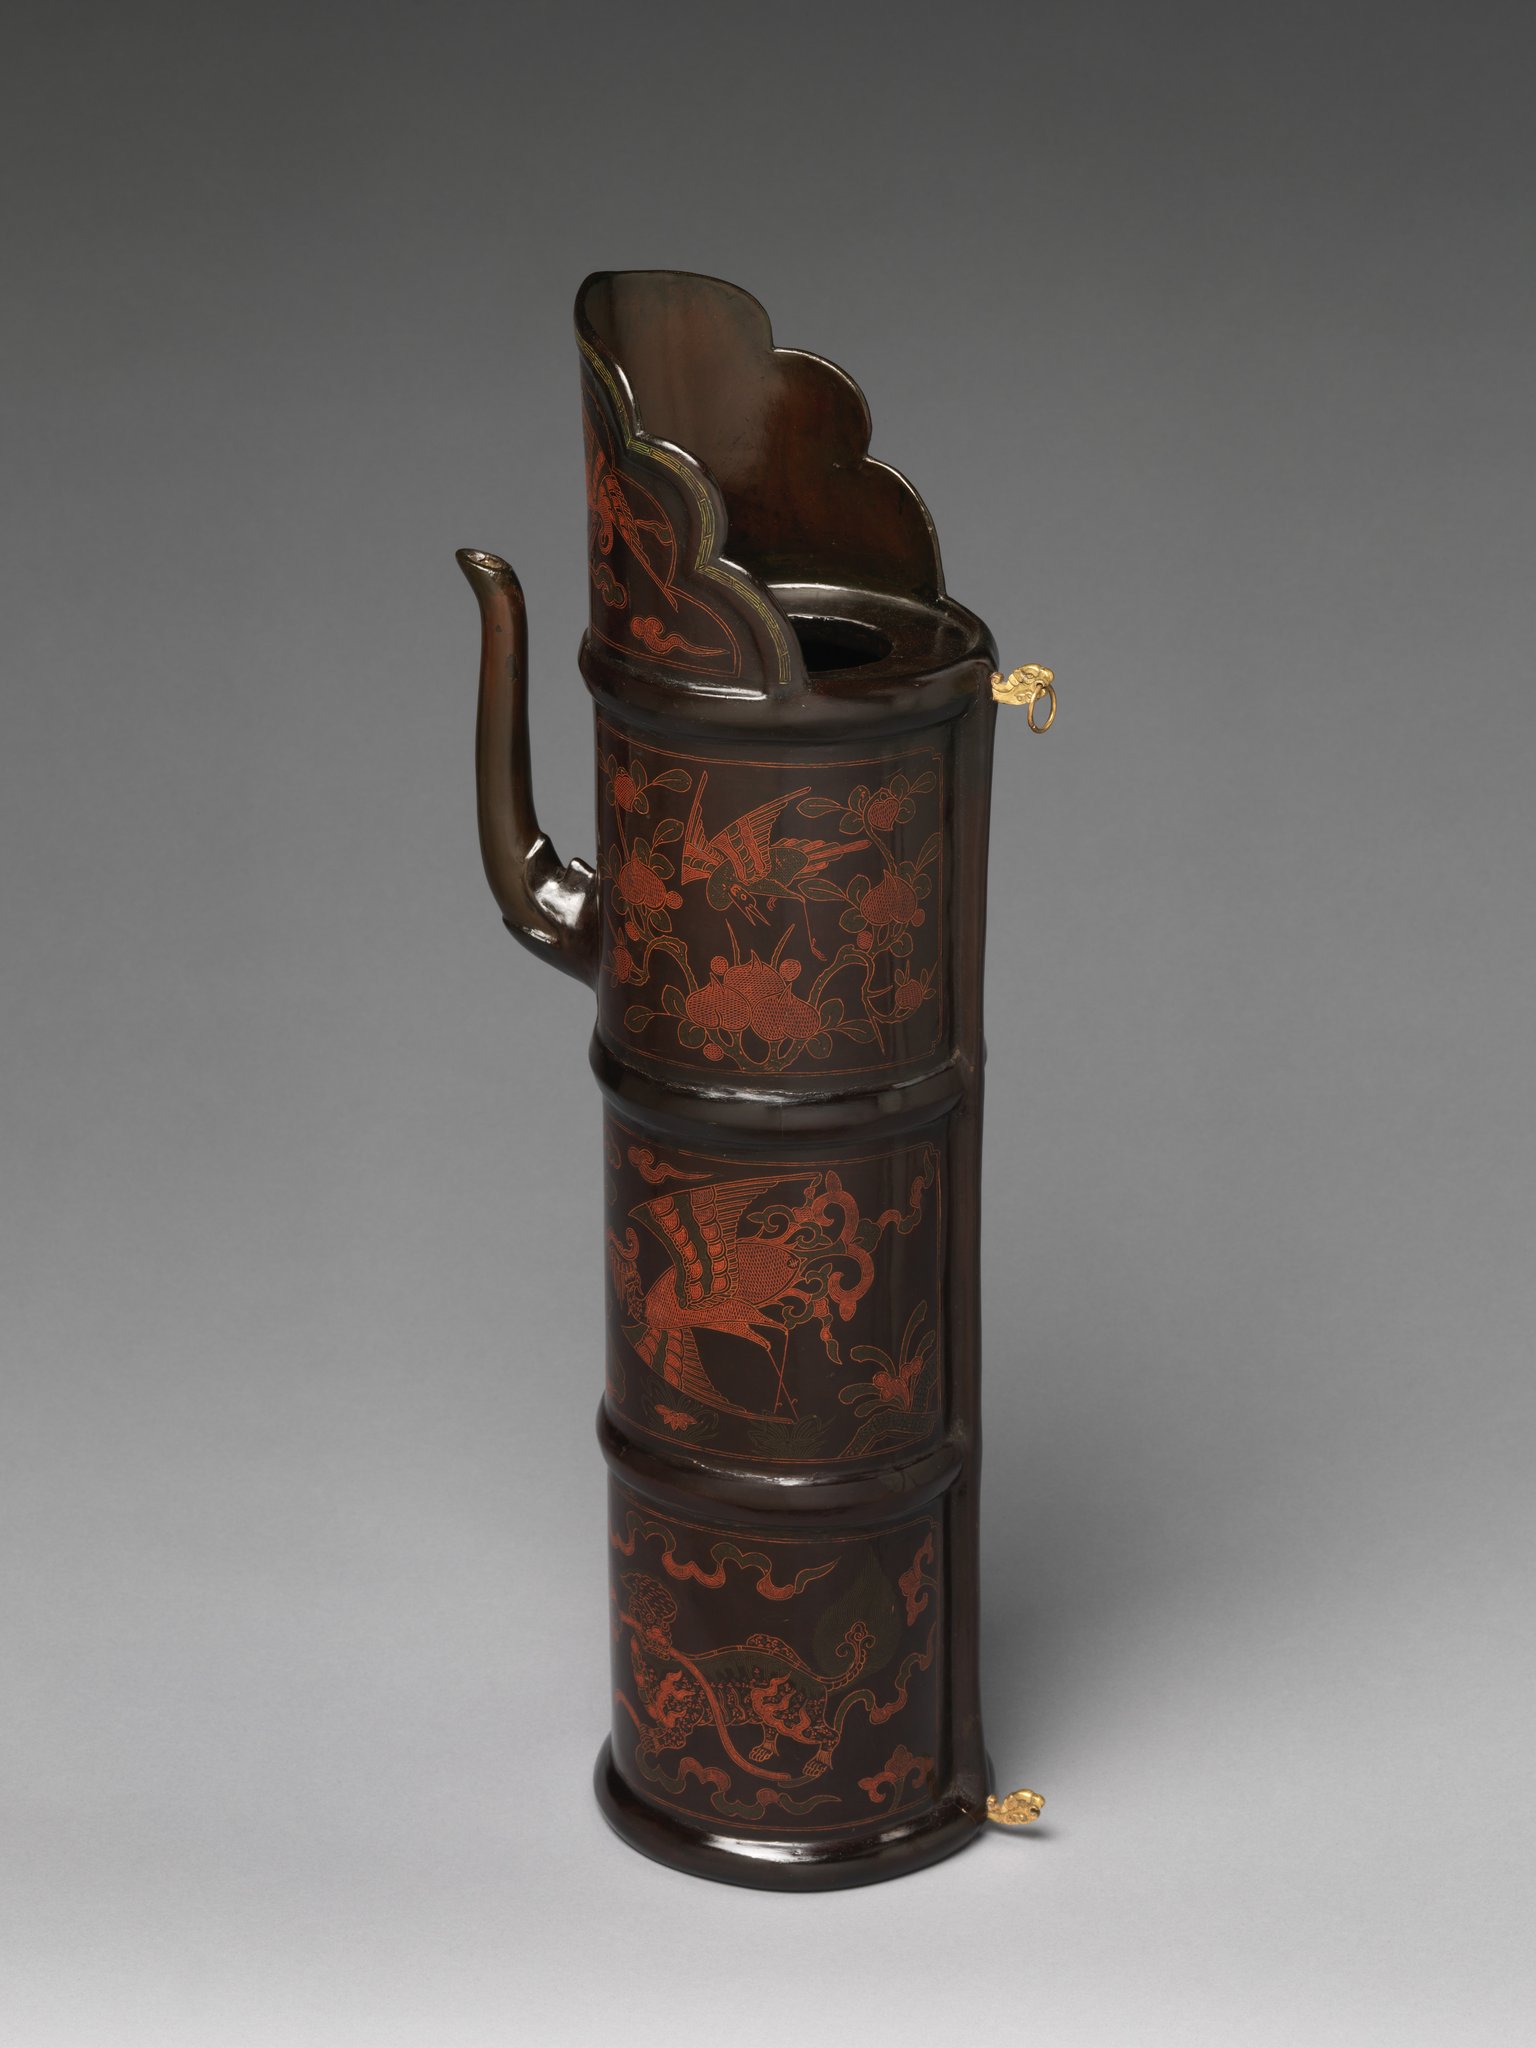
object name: vessel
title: Vessel with mythical creatures, flowers, and birds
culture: chinese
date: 1701-1800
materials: lacquer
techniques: painting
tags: birds,mythical creatures,flowers